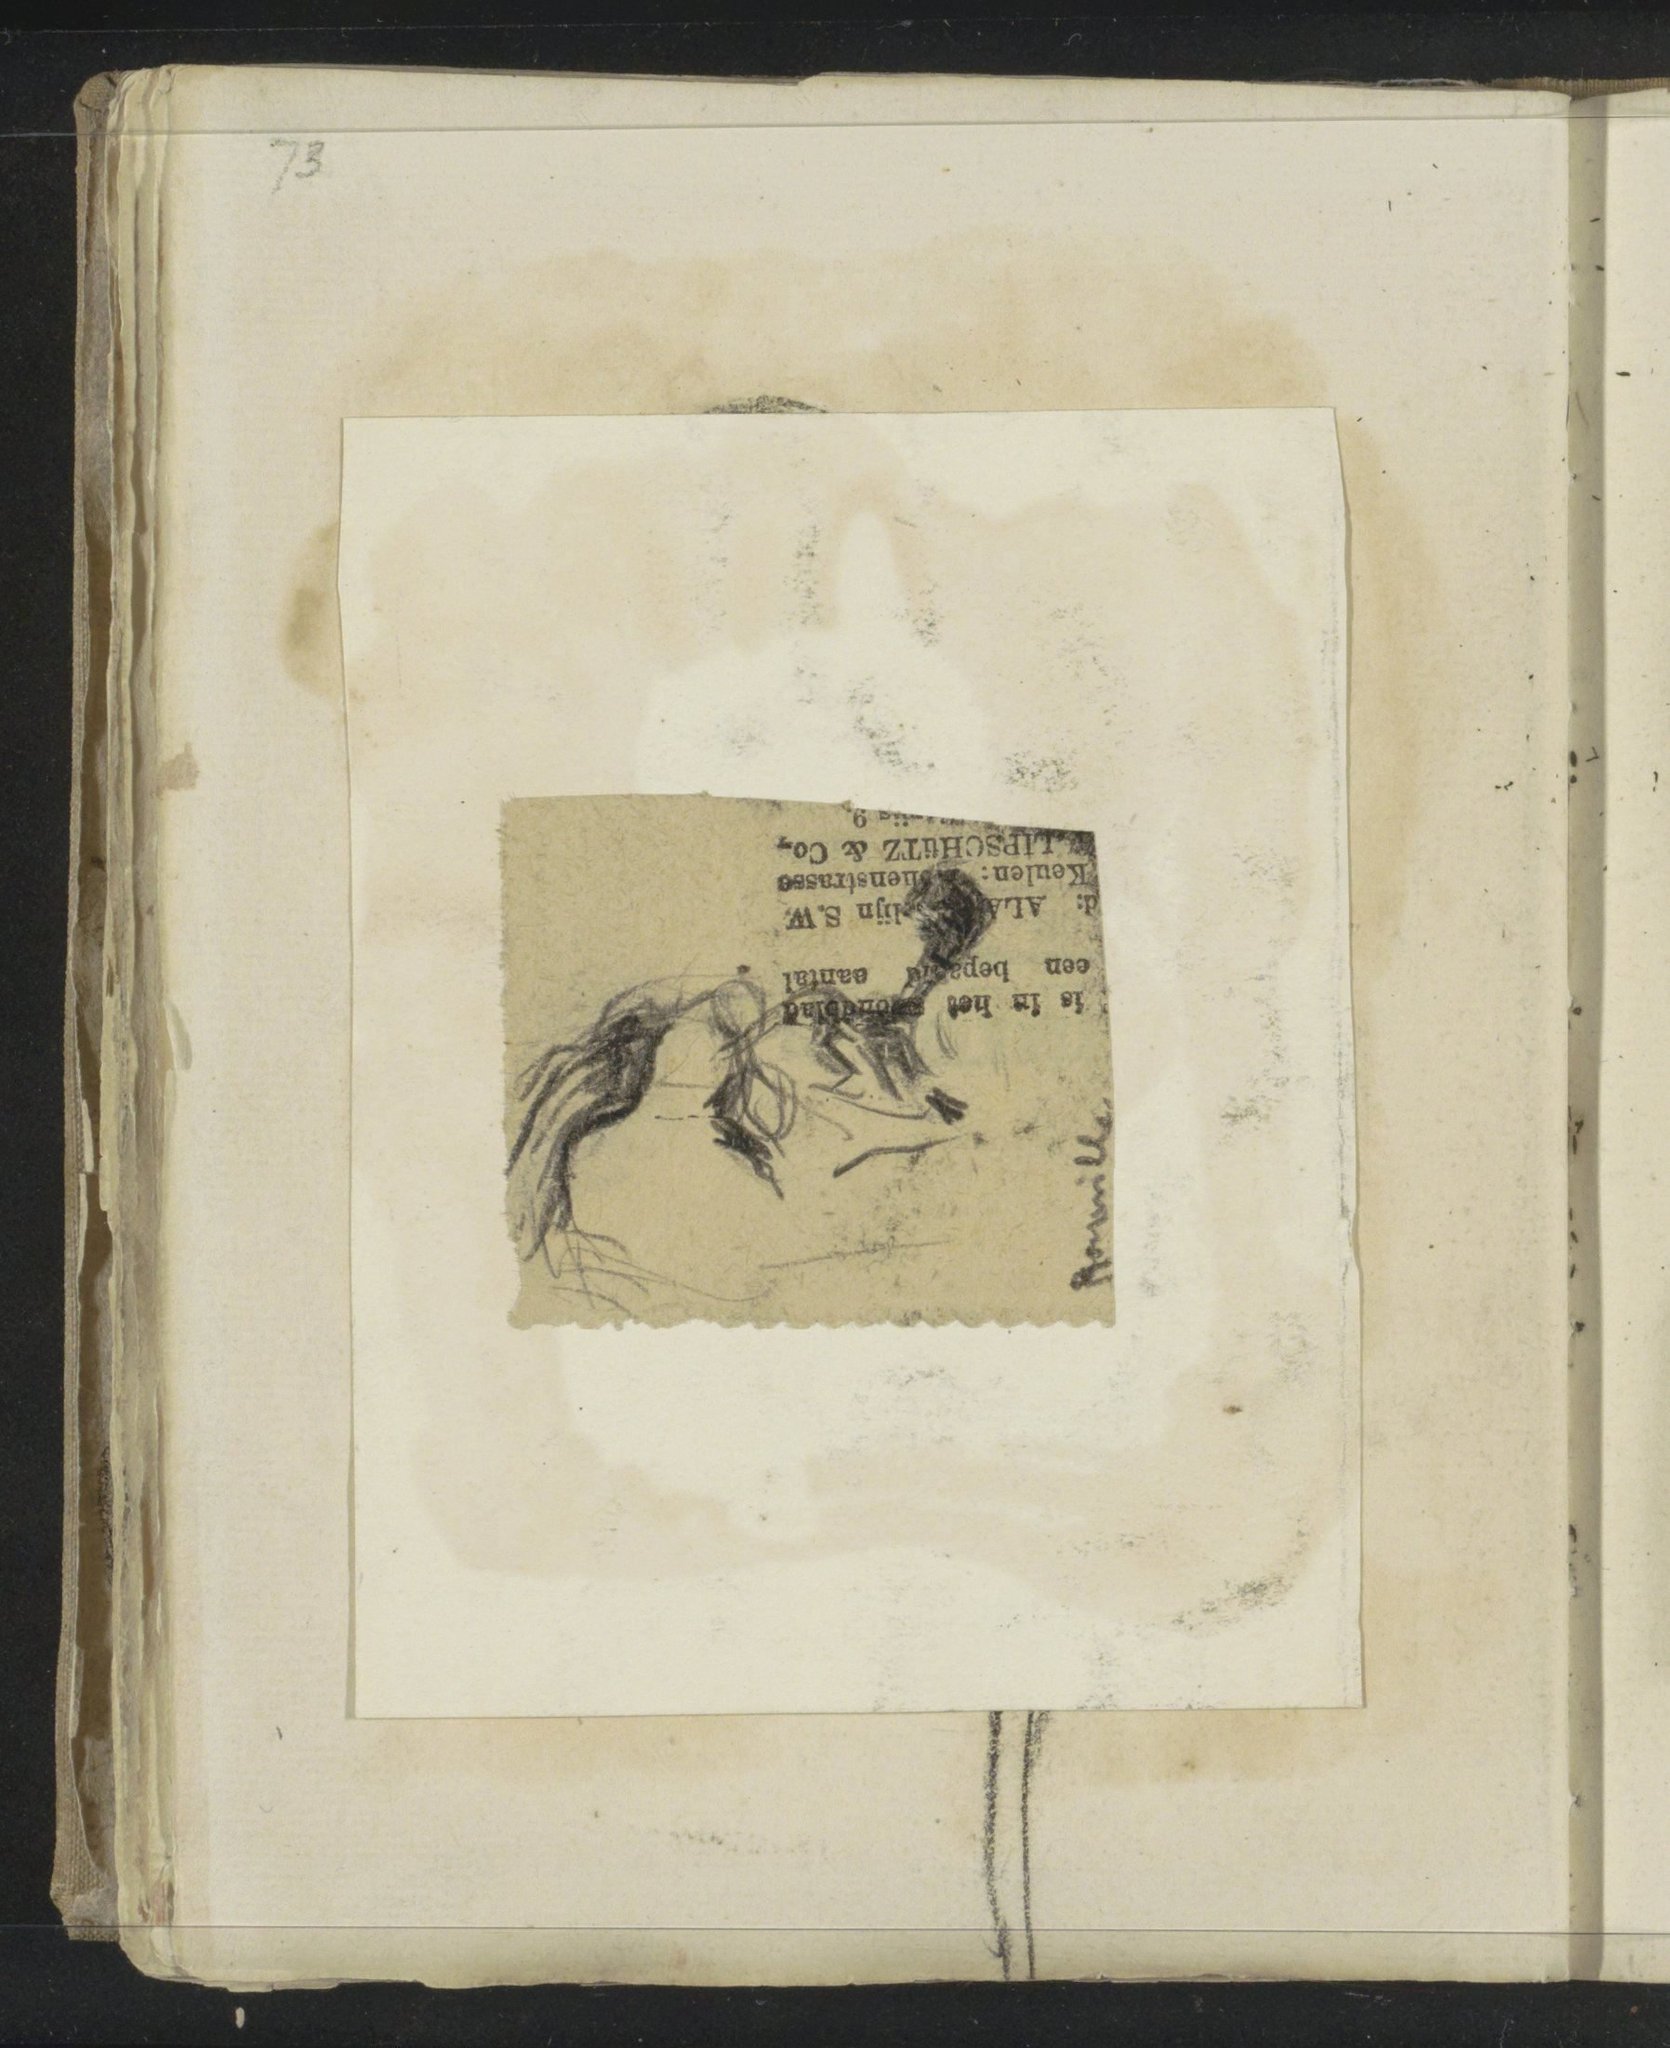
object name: sketchbook leaf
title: Portret van kunstenaar Herman de Rouville de Meux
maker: floris arntzenius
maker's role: draughtsman, print maker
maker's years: 1864-1925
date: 1883-1914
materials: chalk, paper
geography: the hague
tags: the hague, print maker, herman de rouville de meux, portrait, self-portrait of artist, pipe ~ tobacco (+ taking (particular) foodstuffs: eating, drinking, smoking, chewing, etc.)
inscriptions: name: ‘Rouville’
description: Hij rookt een pijp. Blad, geplakt op pagina 73 uit een schetsboek met 82 pagina's.